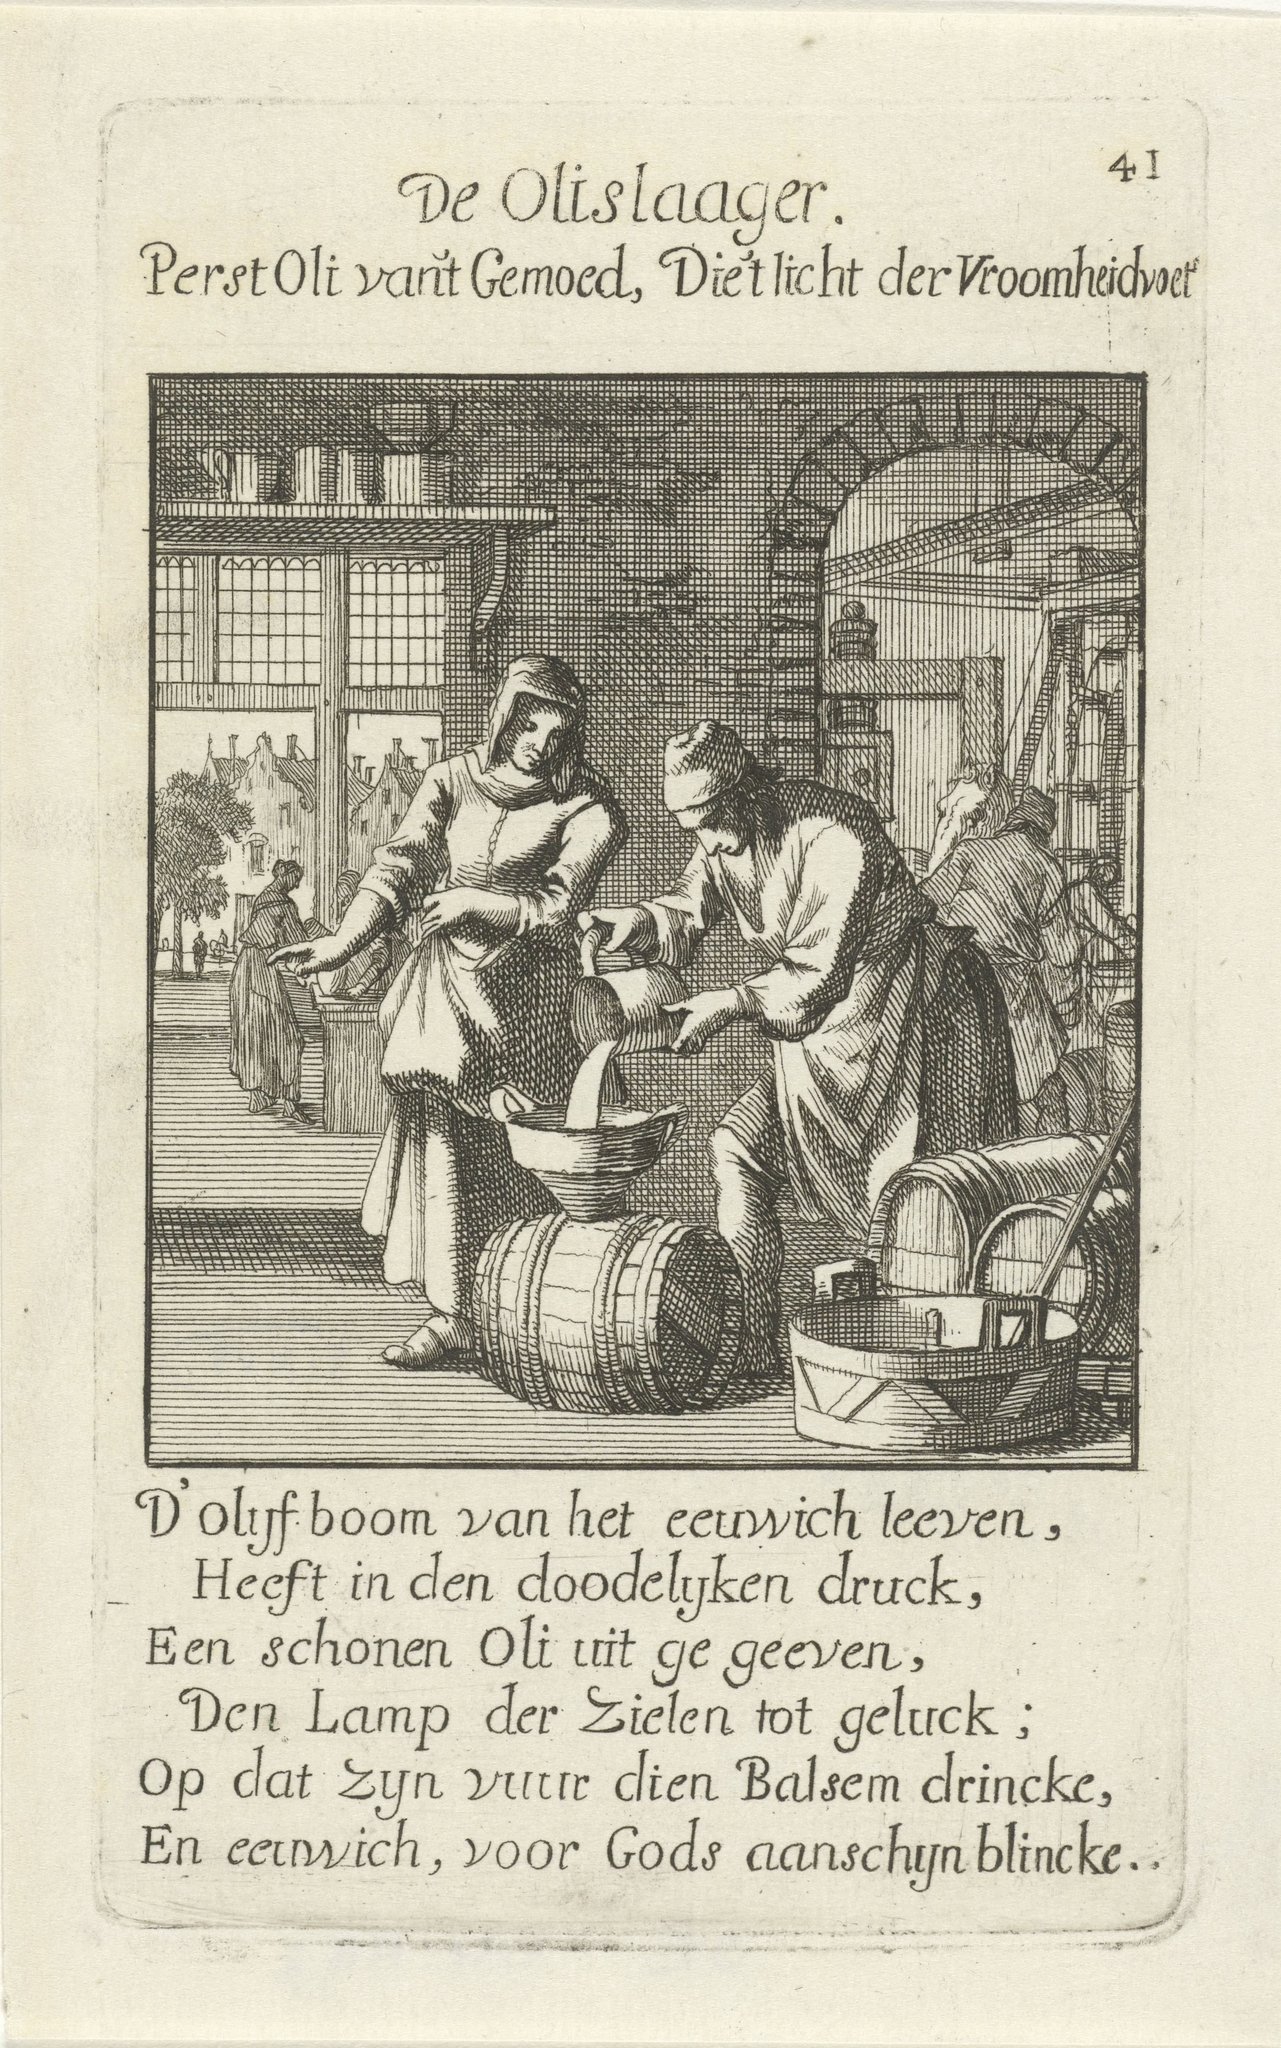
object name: print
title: De Olislaager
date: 1694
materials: paper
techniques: etching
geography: amsterdam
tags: pressing (industrial process) (+ oil ~ crafts, industries, agriculture), handicrafts, craftsman at work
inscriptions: collector's mark: Lugt 2228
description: Maakt deel uit van de 100-delige serie beroepsprenten van Jan en Caspar Luyken, getiteld: Het menselyk bedryf. S.l.s.n., 1694 (eerste druk).